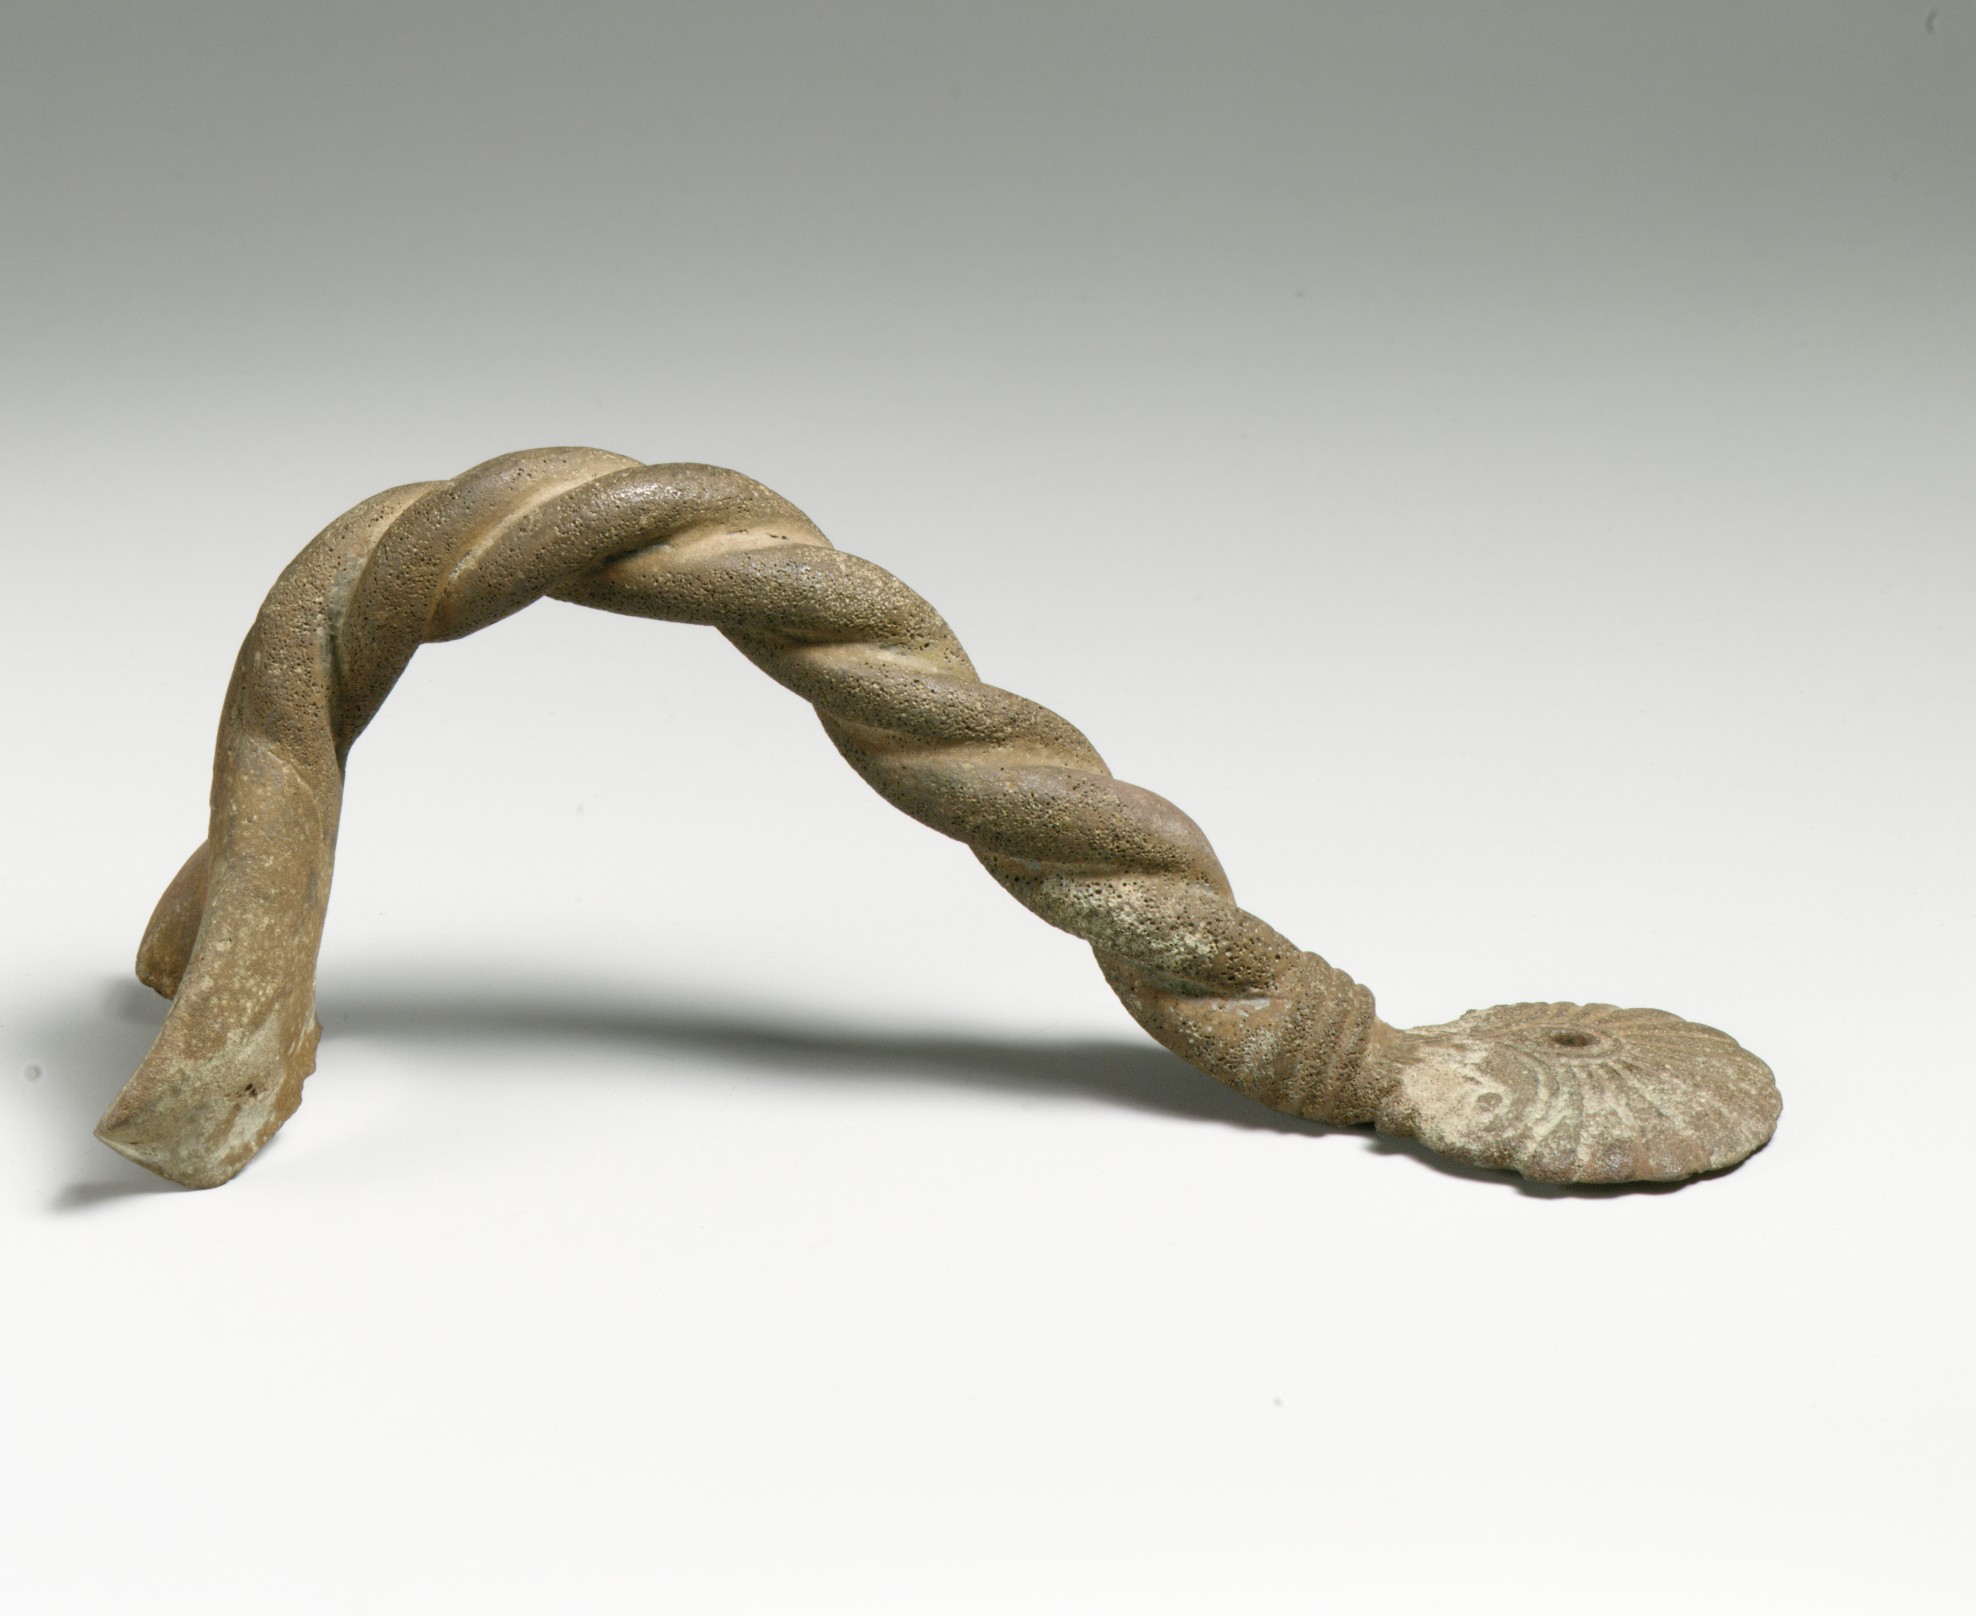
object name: handle of a jug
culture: cypriot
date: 600-501 BCE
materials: bronze